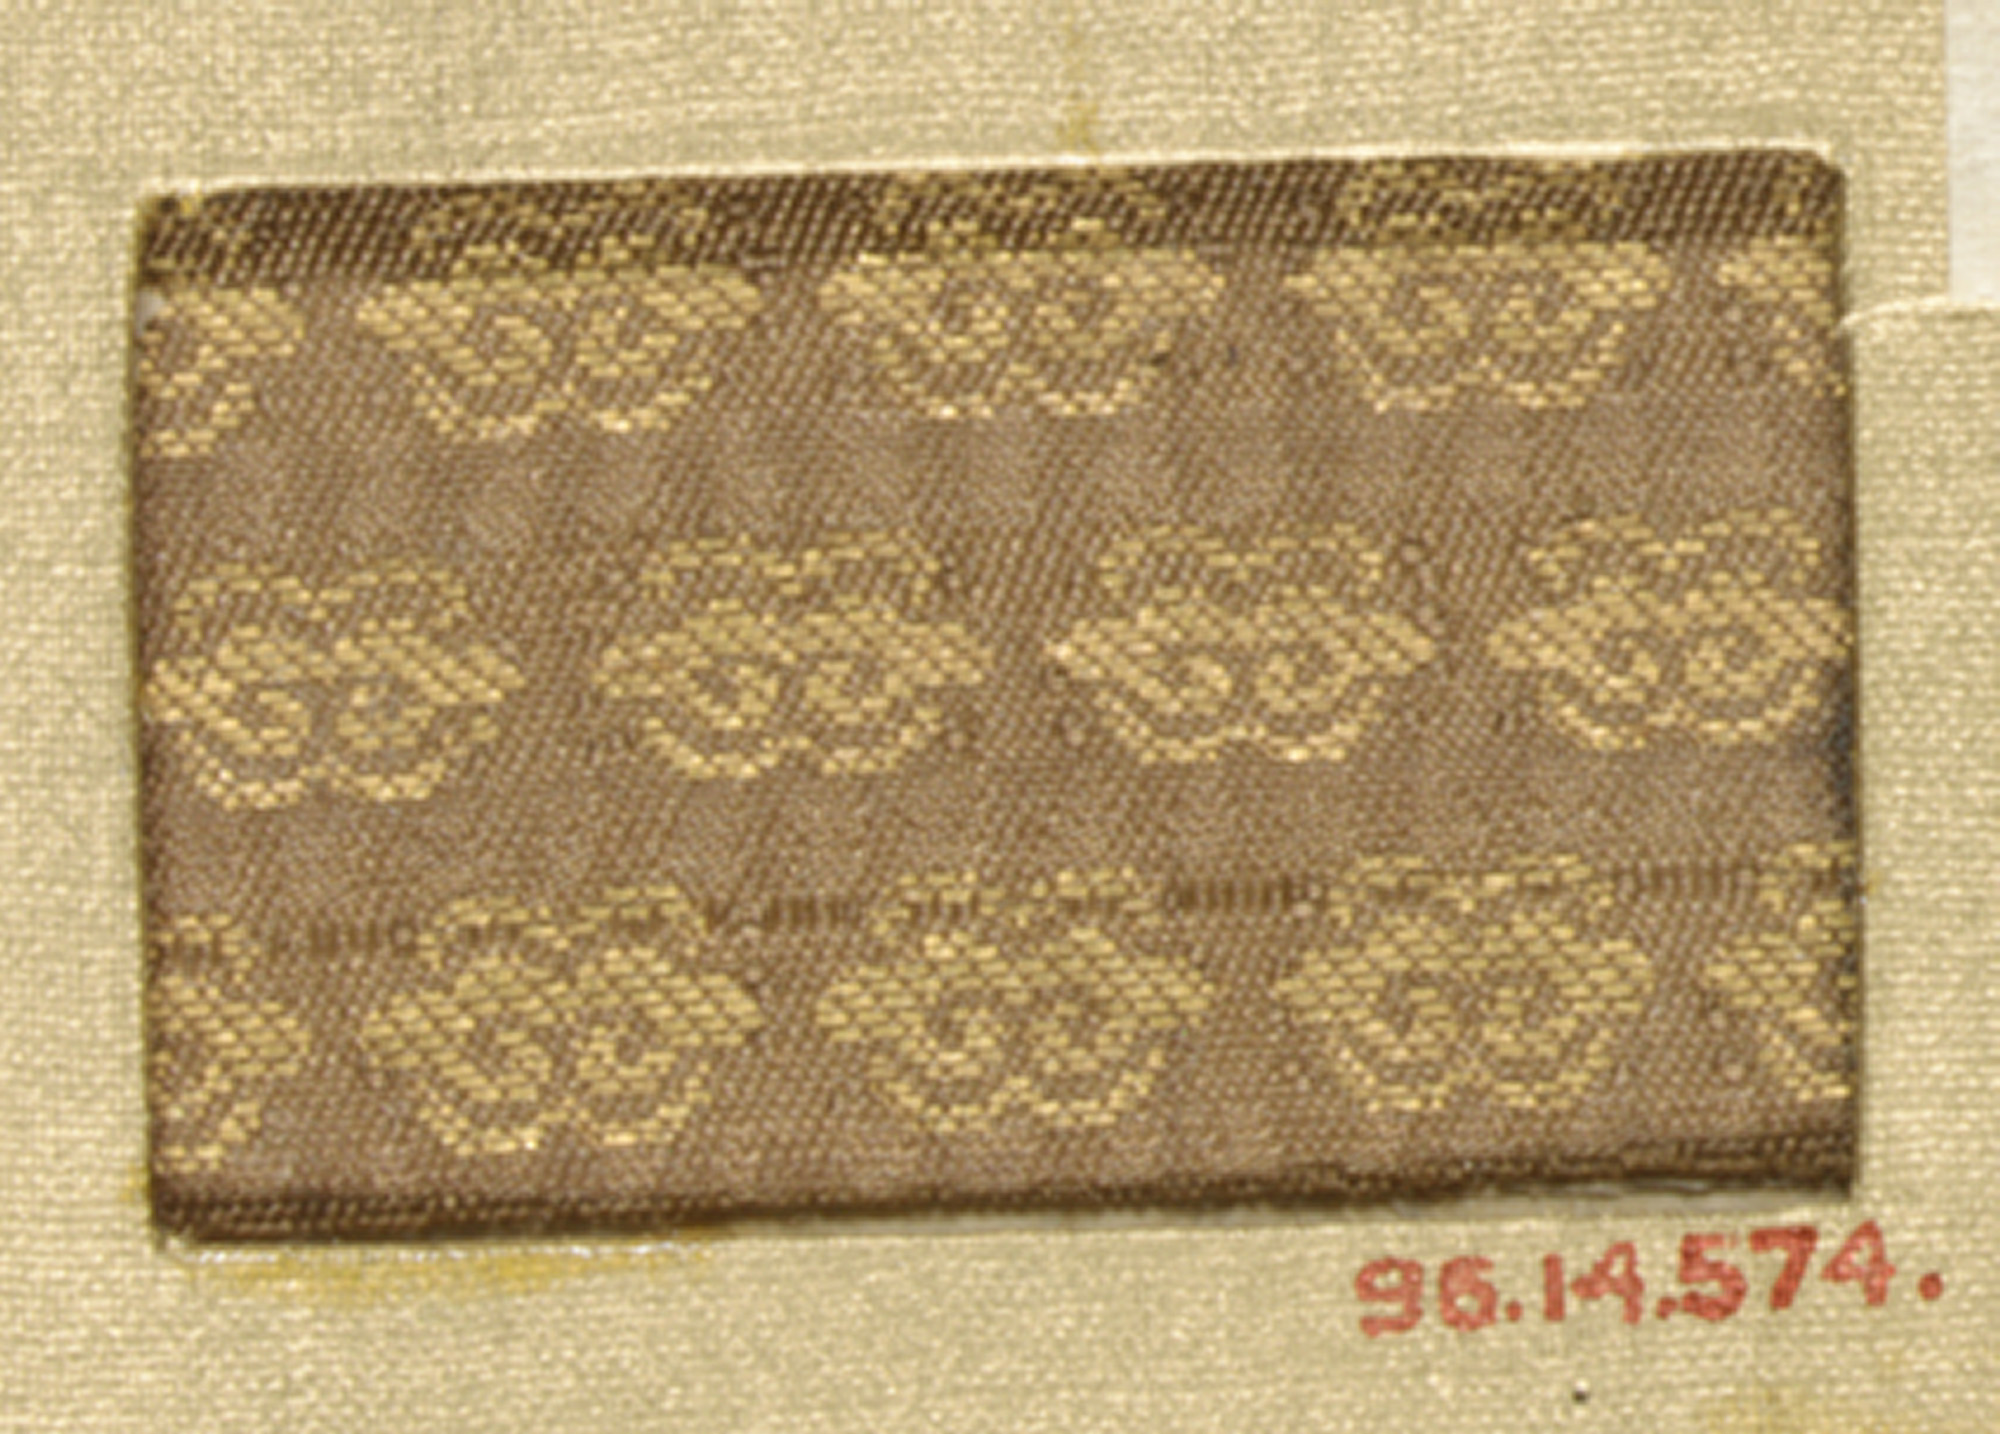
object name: piece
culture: japanese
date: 1701-1900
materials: silk